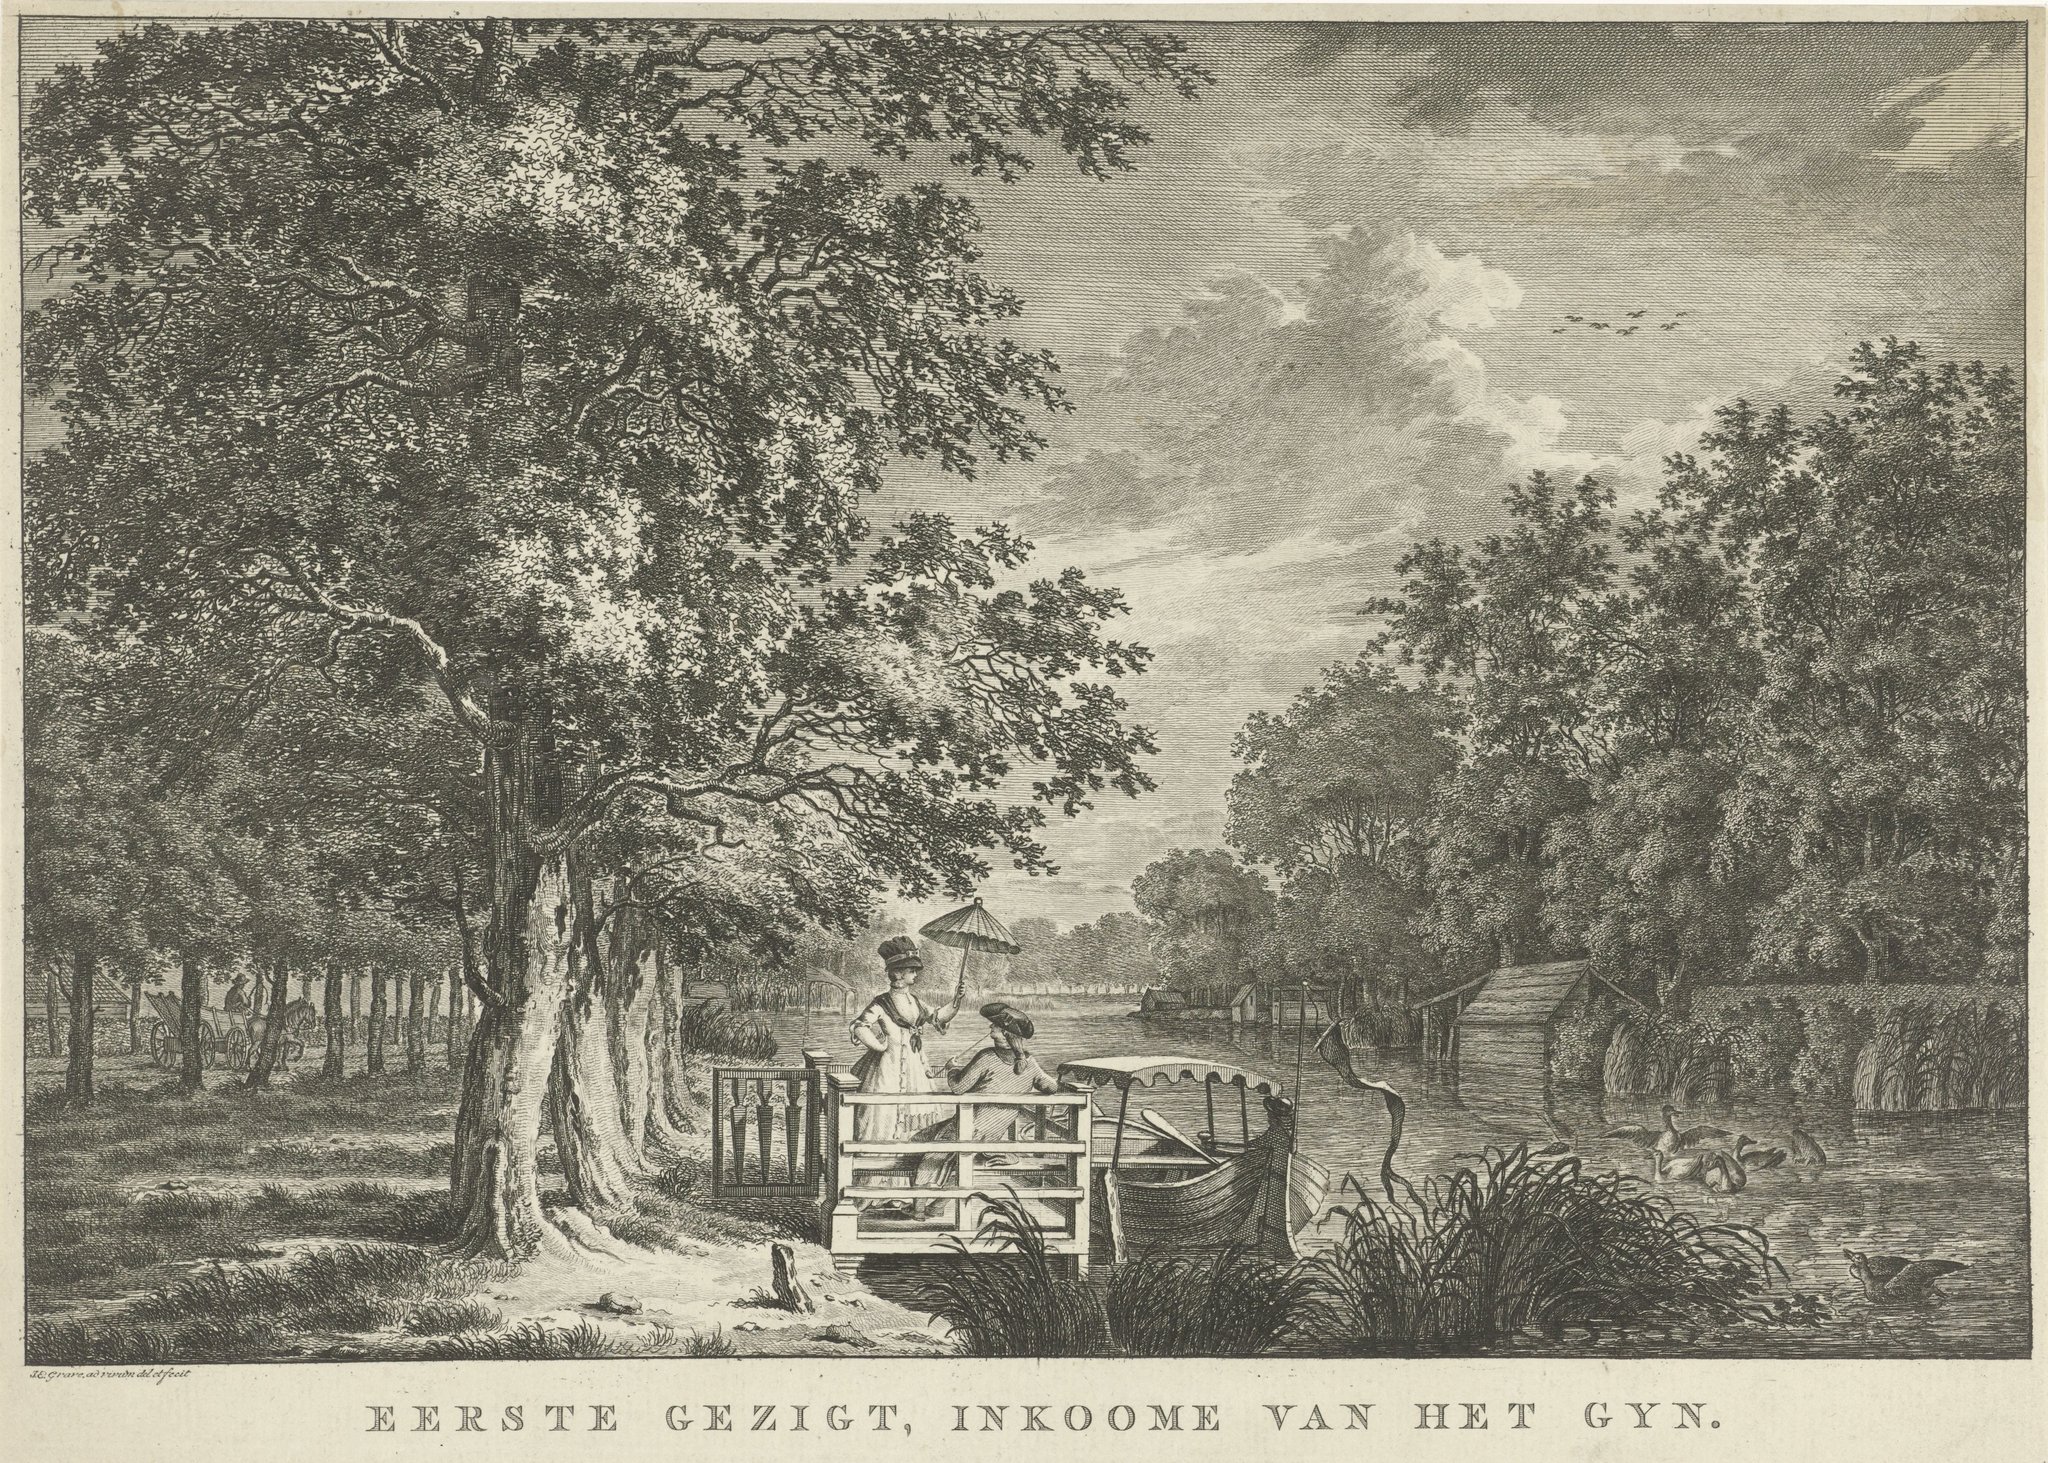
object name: print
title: Eerste gezigt inkoome van het Gyn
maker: jan evert grave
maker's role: draughtsman, print maker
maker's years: 1759-1805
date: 1769-1805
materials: paper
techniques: engraving, etching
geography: amsterdam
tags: pipe ~ tobacco, river (+ landscape with figures, staffage), parasol, sunshade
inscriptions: collector's mark: Lugt 2228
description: De oever van de rivier het Gein bij Amsterdam. Op de voorgrond een paar bij een aanlegsteiger. De vrouw draagt een parasol. De man rookt een pijp.